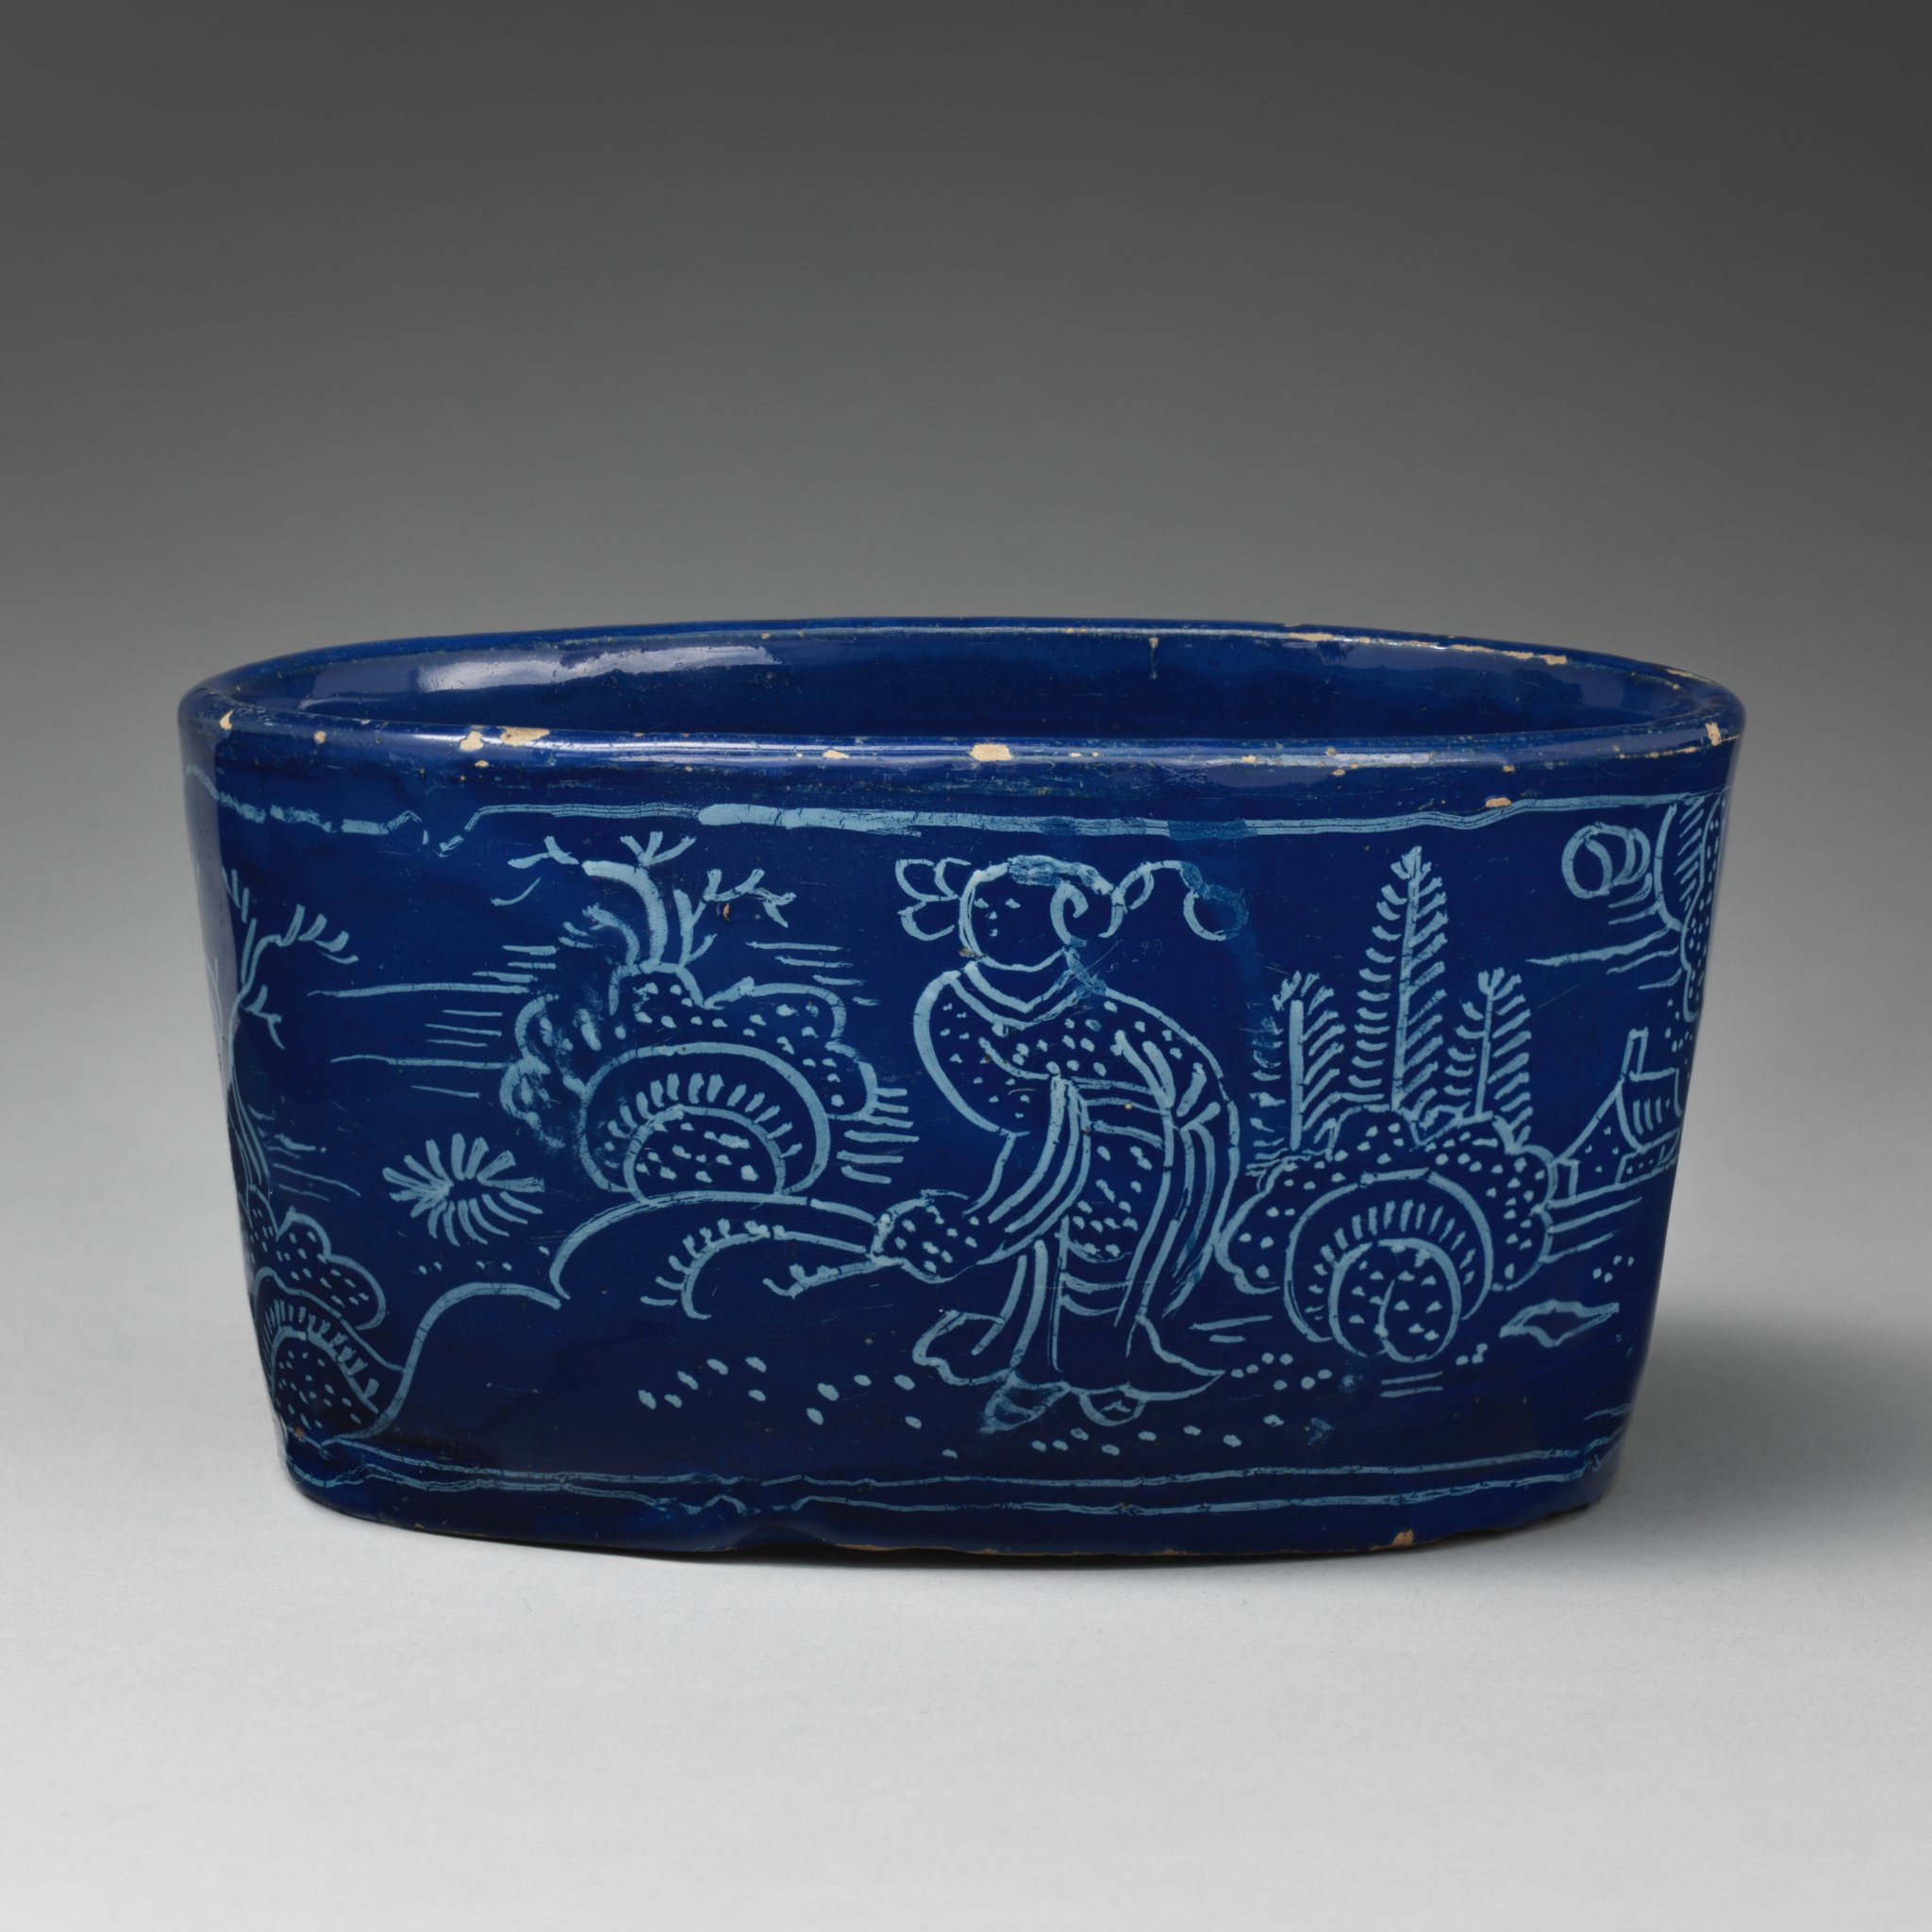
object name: butter dish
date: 1651-1700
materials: earthenware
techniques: glazing